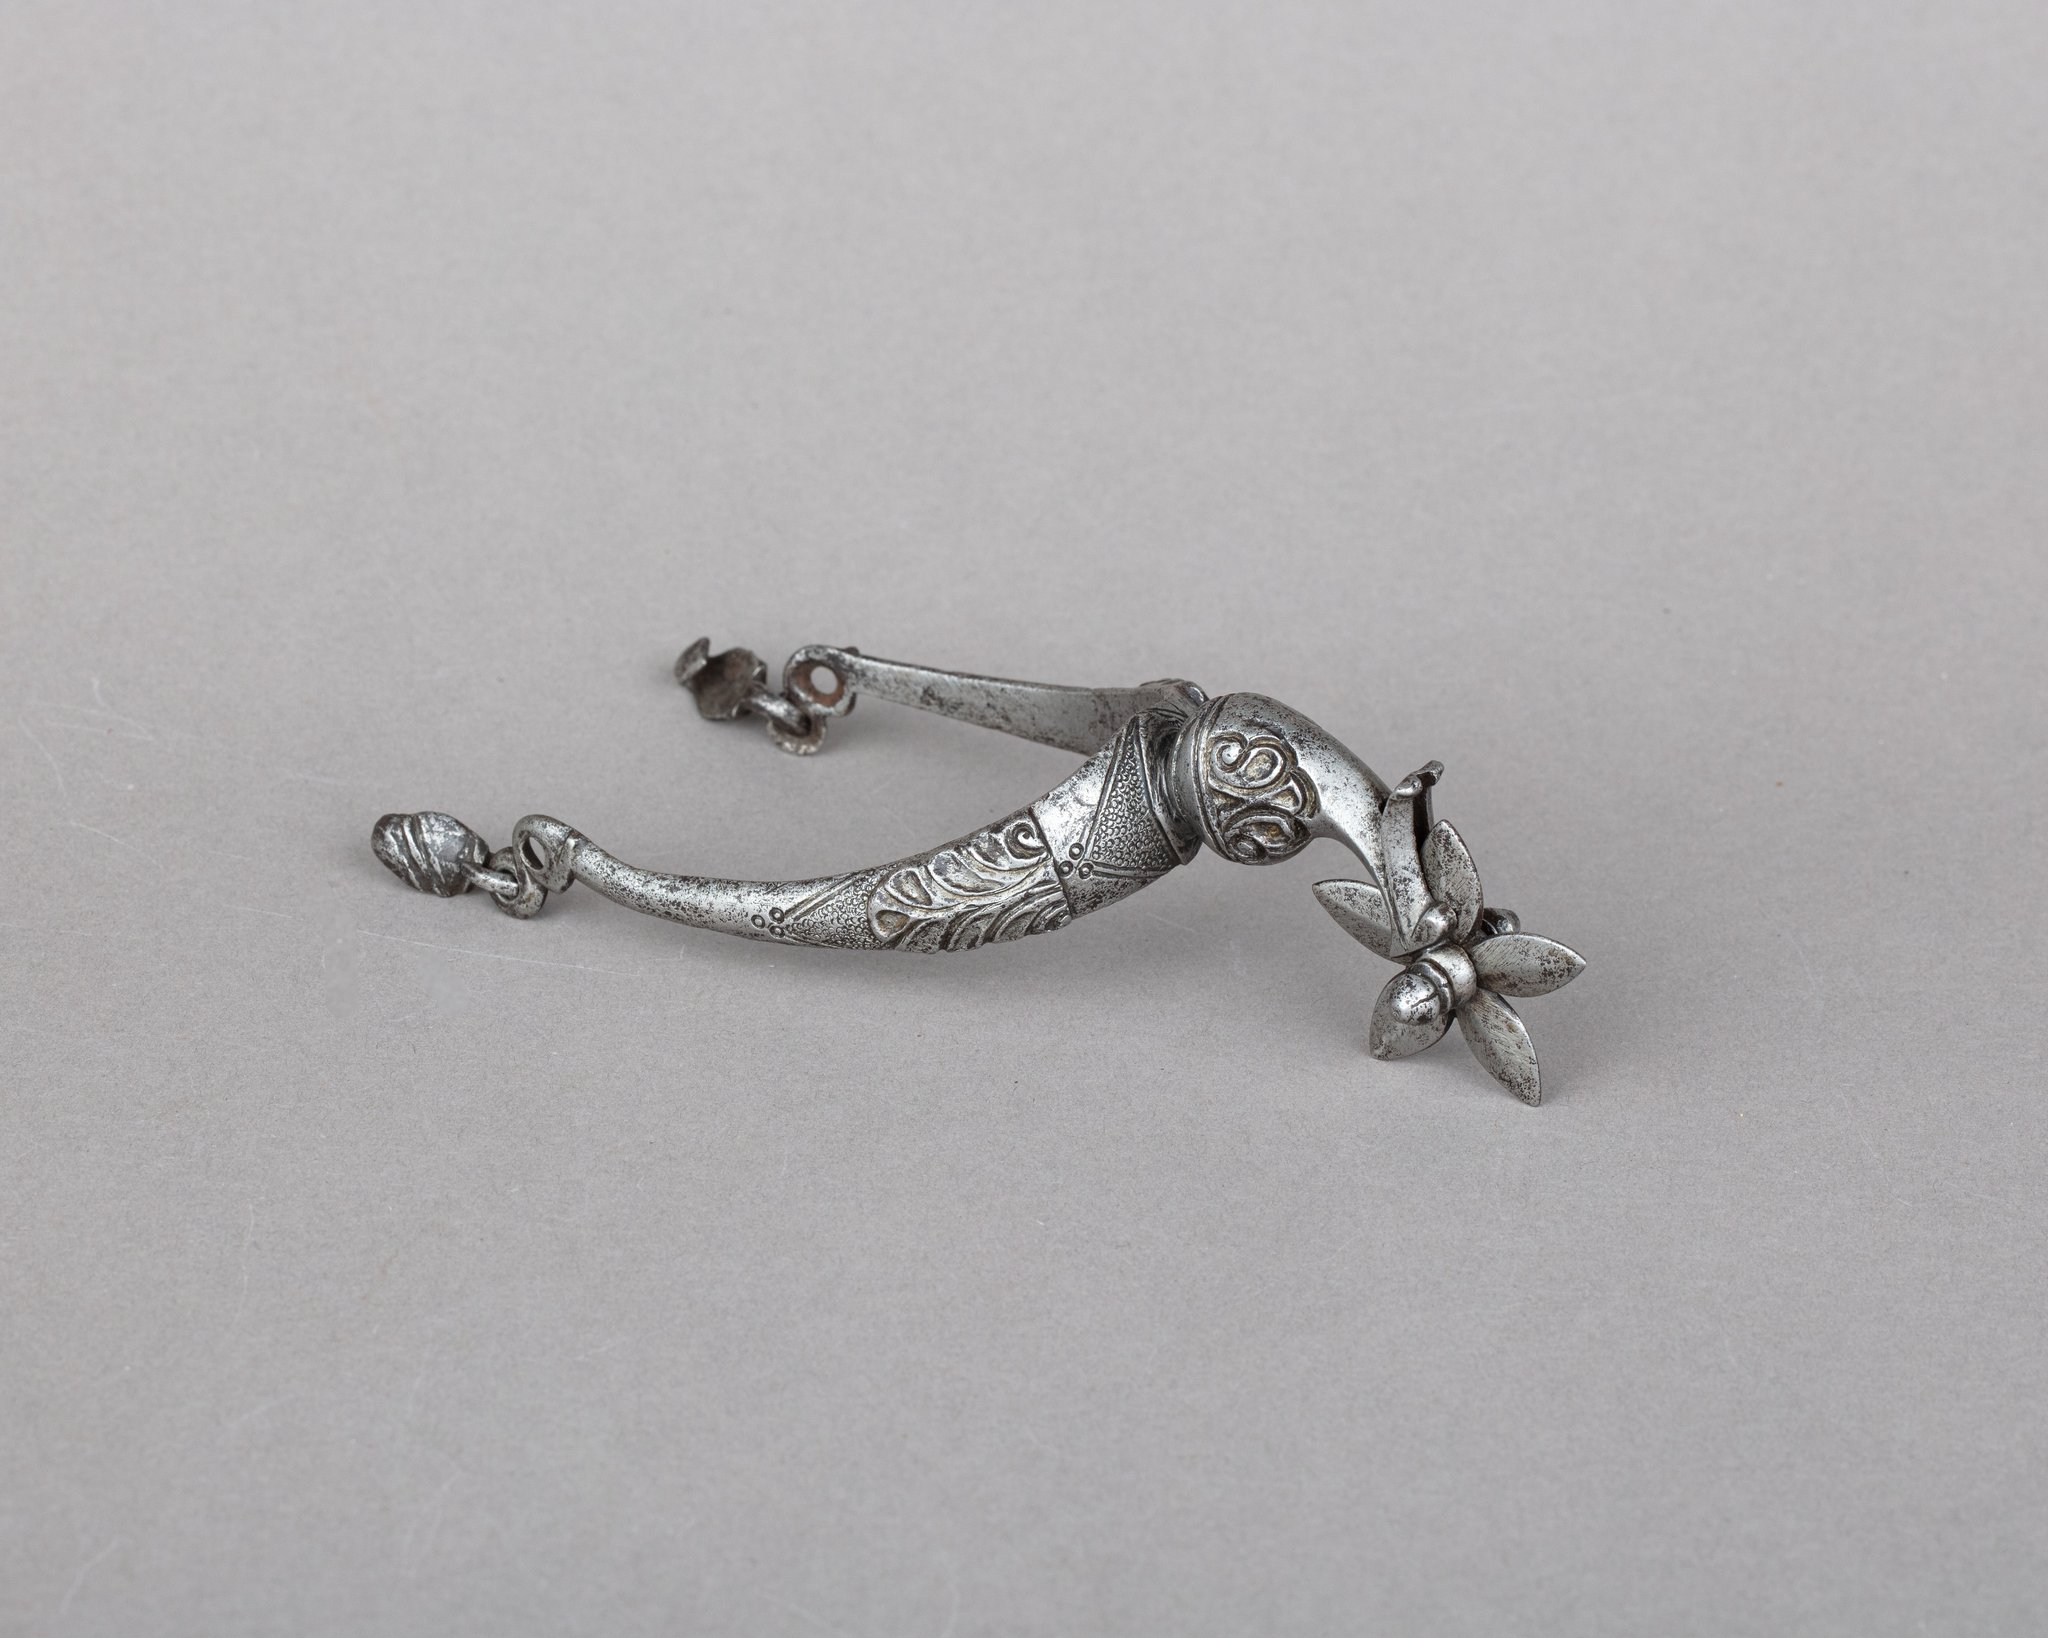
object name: spur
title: Rowel Spur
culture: german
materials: metal alloy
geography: germany